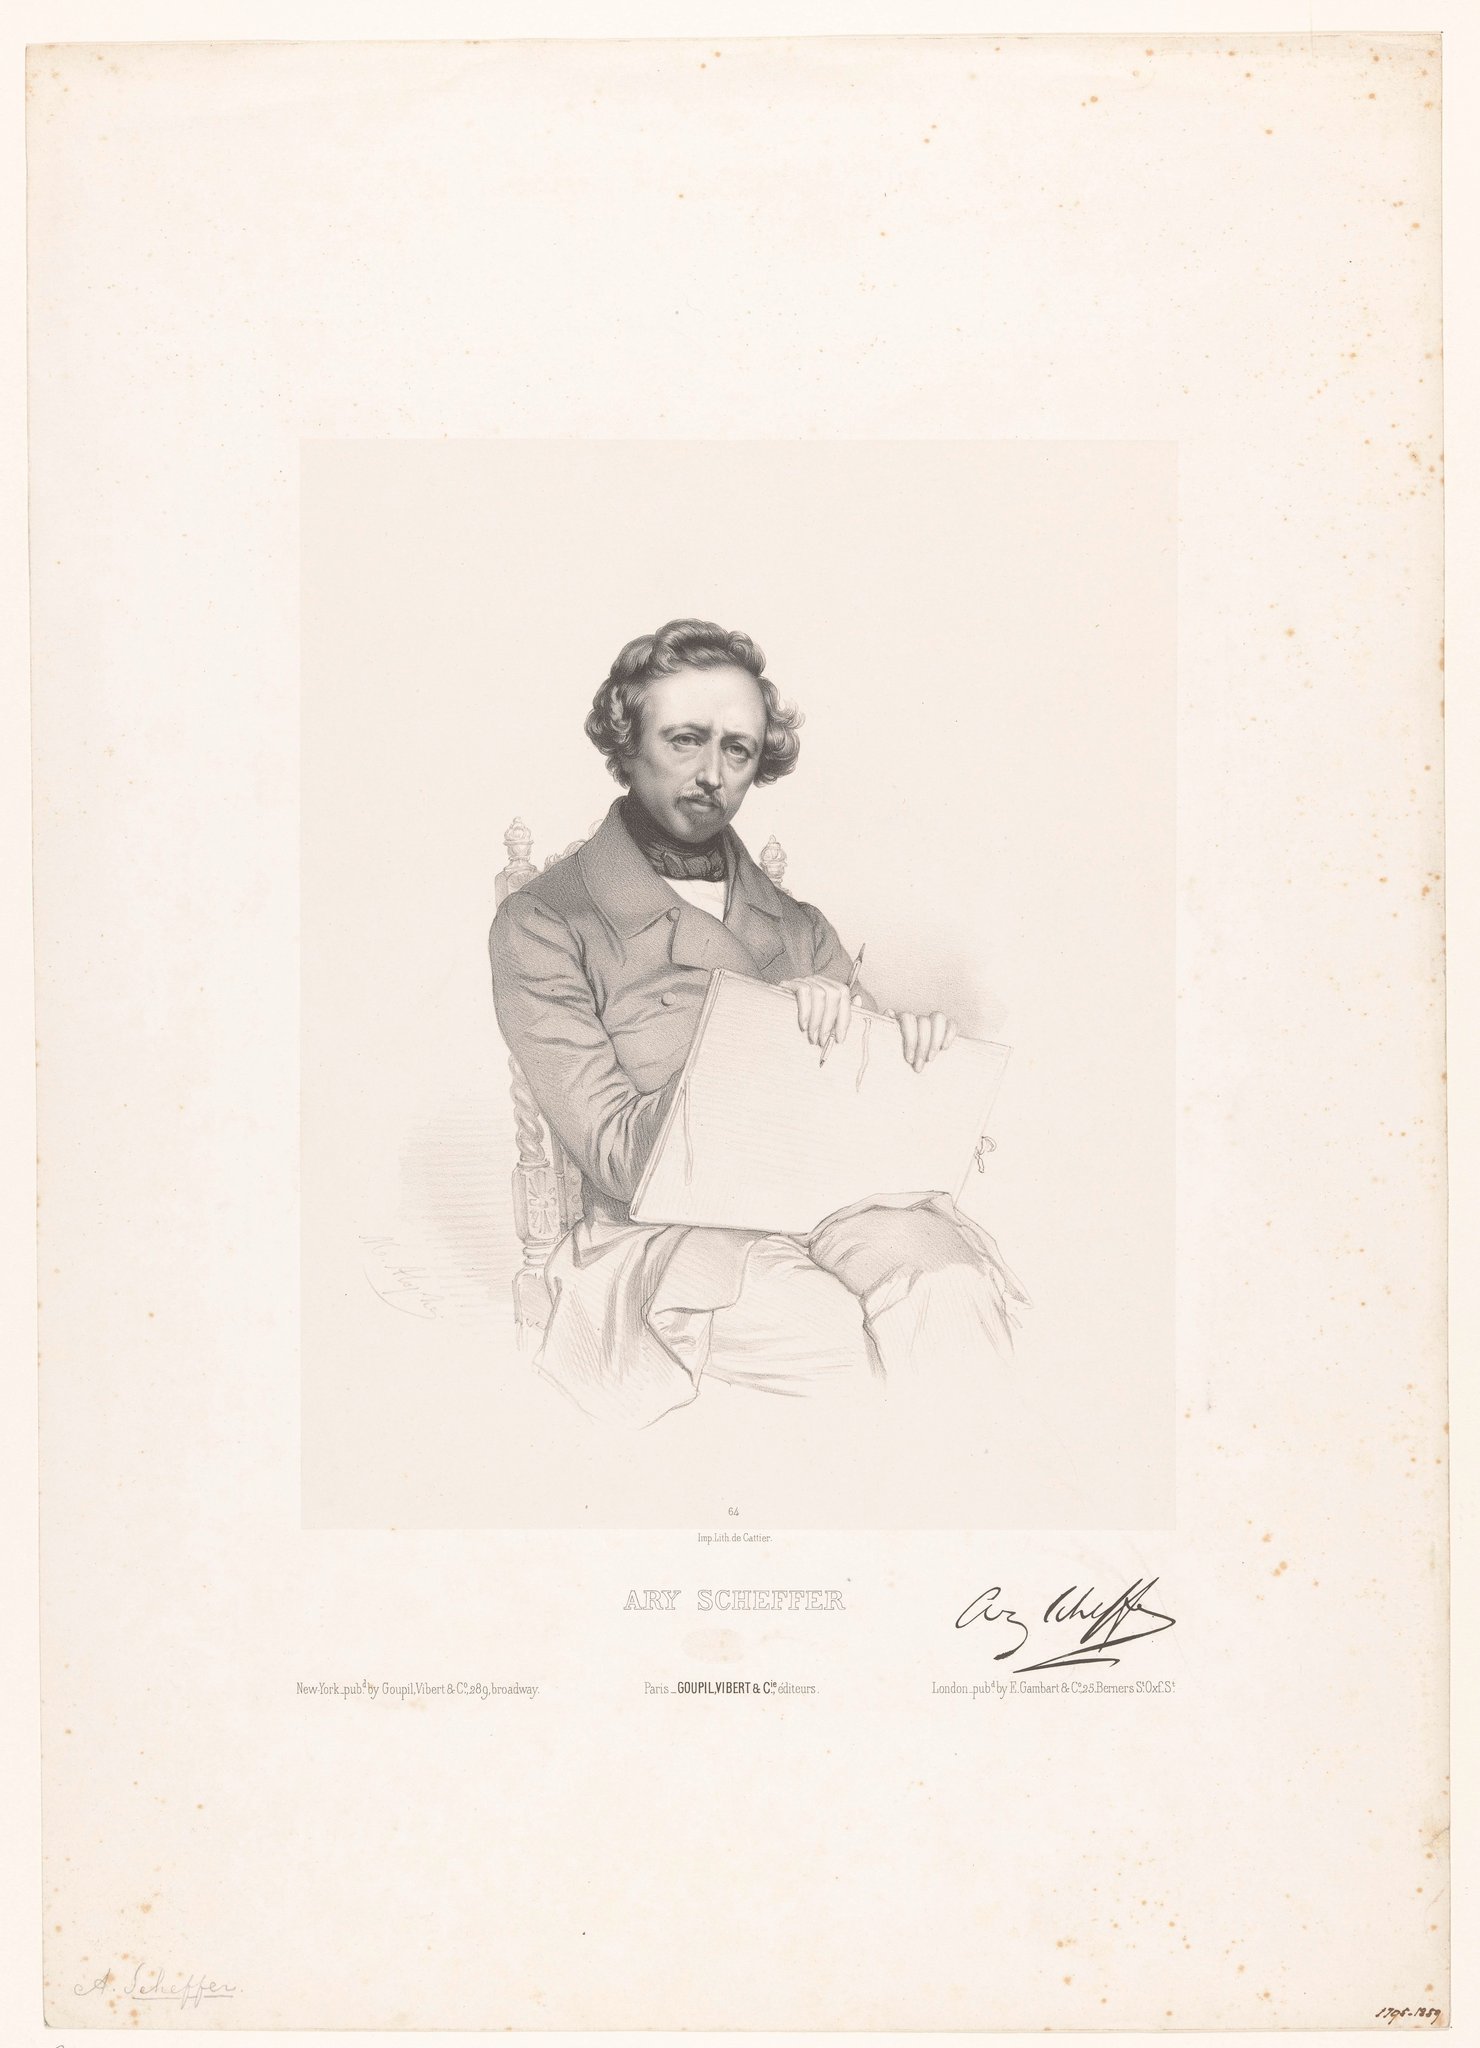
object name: print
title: Ary Scheffer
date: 1848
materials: paper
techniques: lithography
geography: paris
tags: dordrecht, painter, print maker, draughtsman, sculptor, ary scheffer, historical persons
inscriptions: check stamp: Lugt 5004, number: ‘1795-1359’